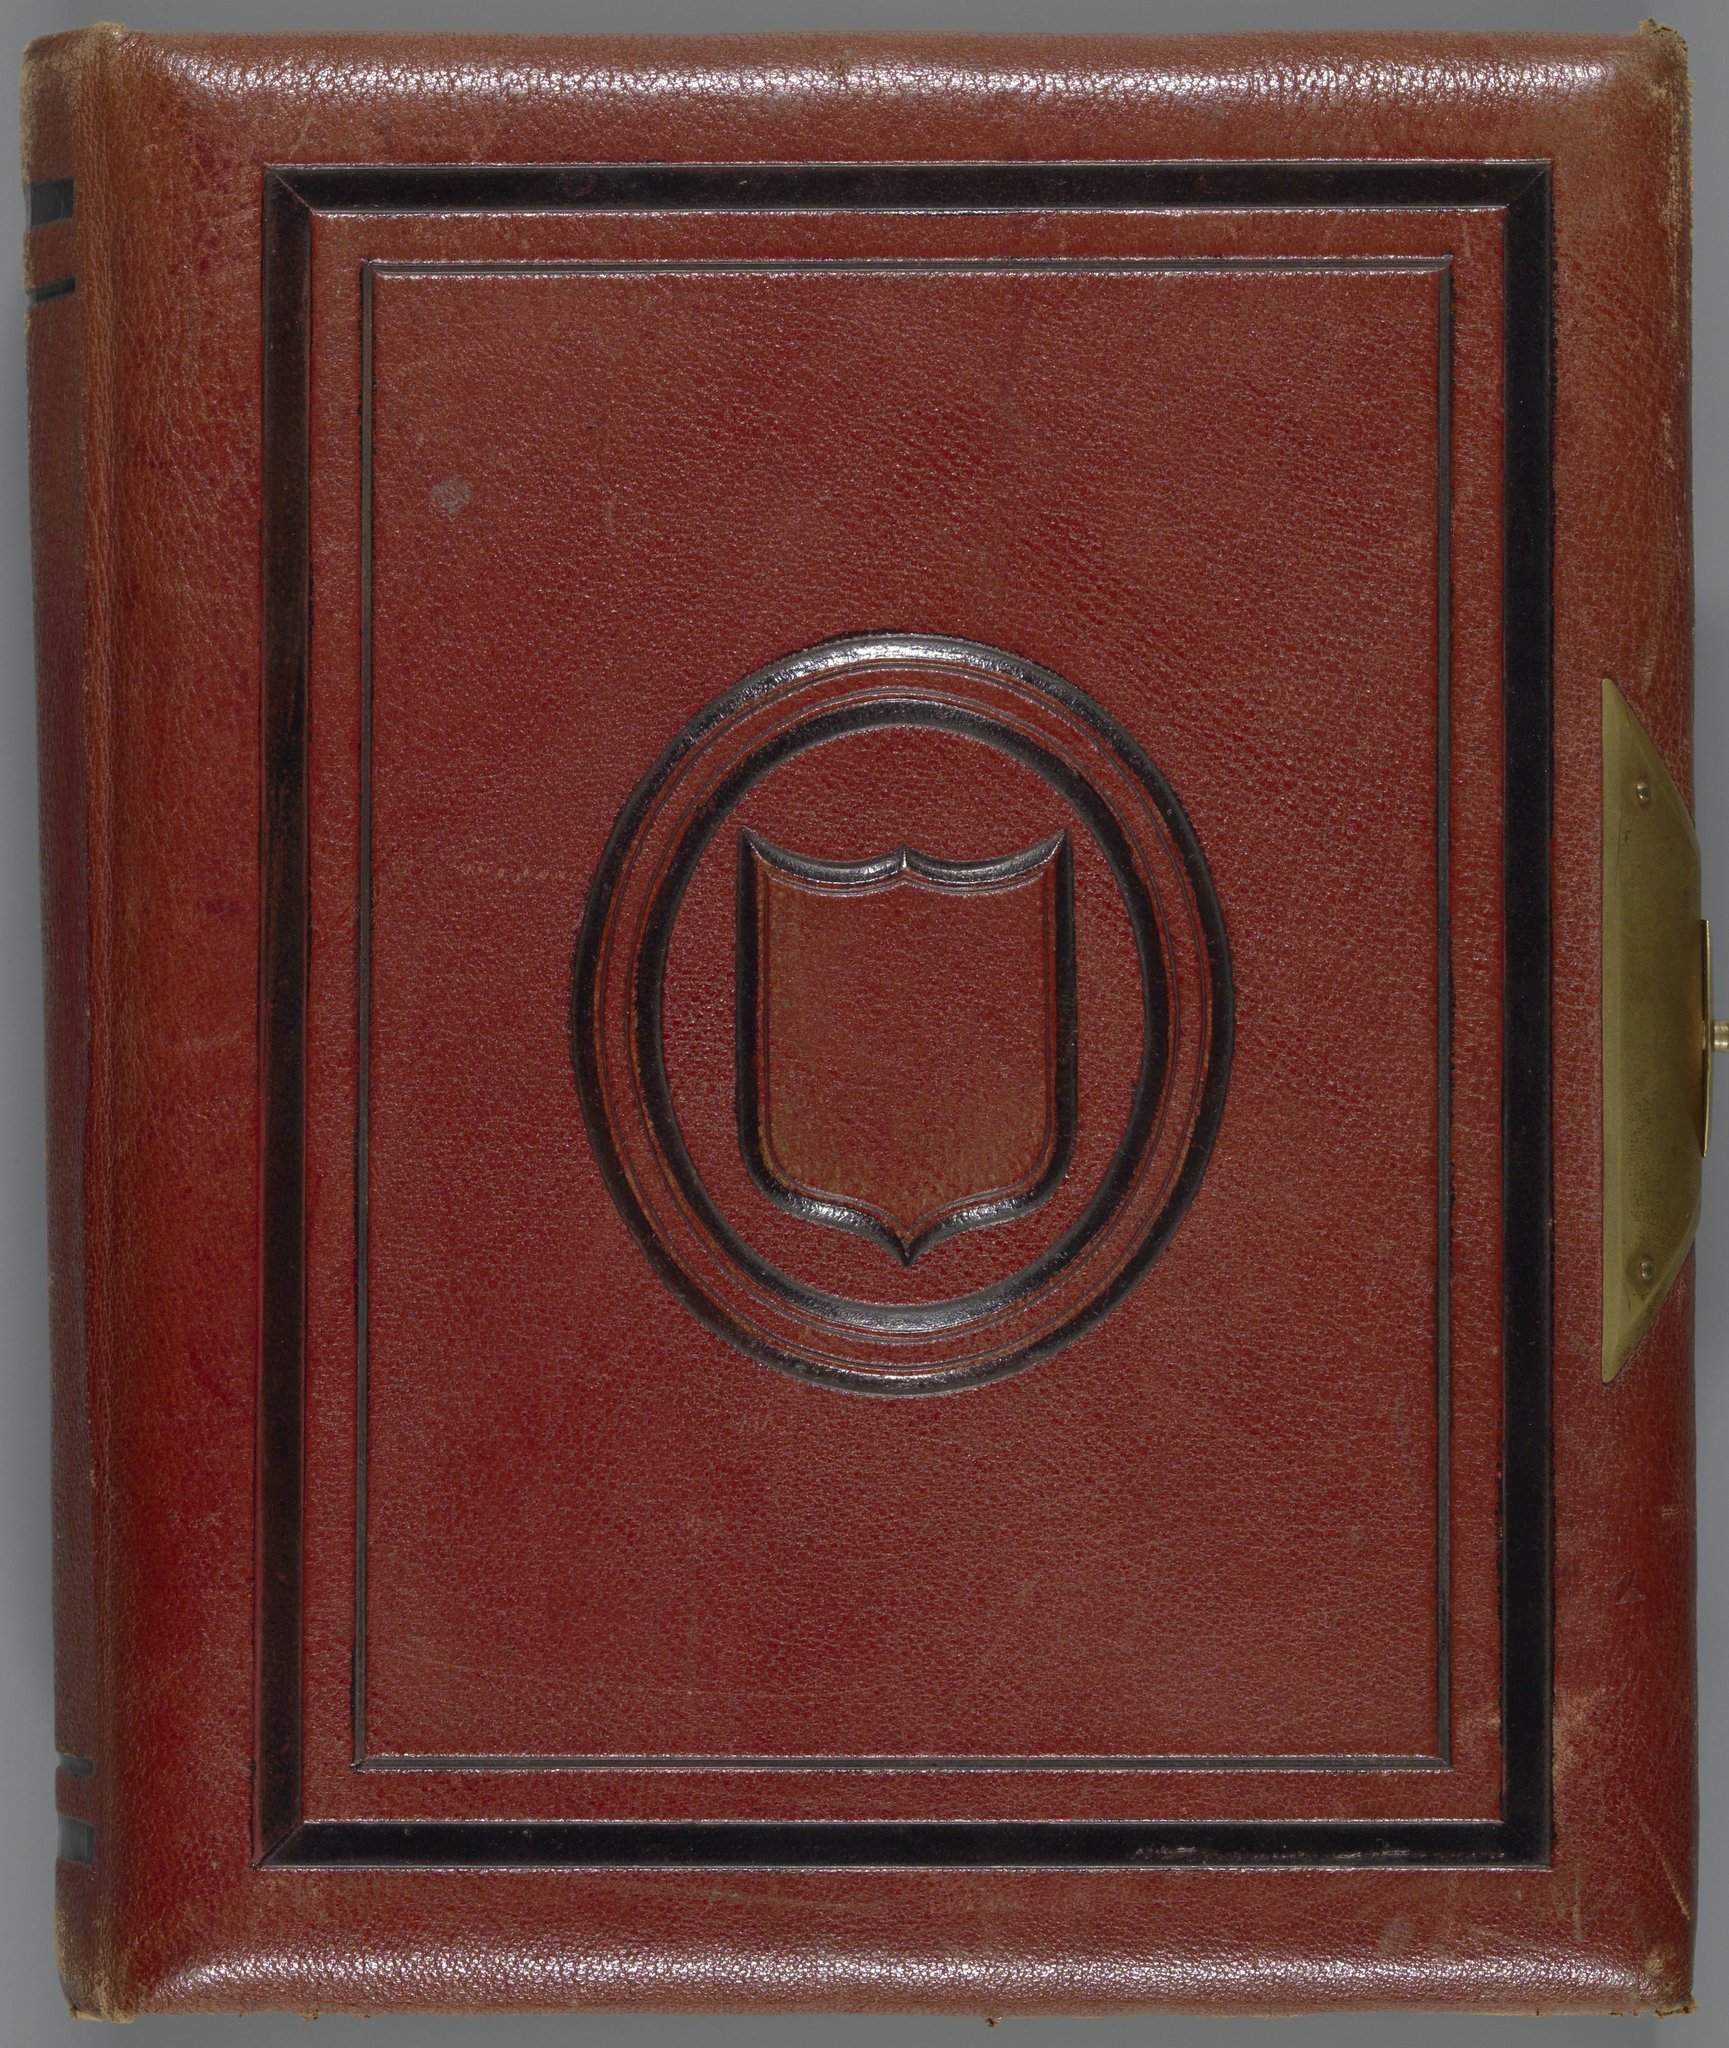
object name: slip in album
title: Fotoalbum met opnames van straten, pleinen en grachten in Amsterdam en van het 25-jarig regeringsjubileum van koning Willem III in 1874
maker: Anonymous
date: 1850-1875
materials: cardboard, copper, leather, paper, photographic support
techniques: albumen print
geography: amsterdam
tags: public festivities on the occasion of royal events, commemoration, jubilee (+ the public ~ festive activities), prospect of city, town panorama, silhouette of city, amsterdam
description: Fotoalbum in rode leren band met koperen slot. Het voor- en achterplat zijn versierd met een wapenschild en kaders in reliëf. De schutbladen zijn van changeant papier. Het album bevat 24 dikke kartonnen bladen goud op snee met in totaal 48 kabinetfoto's in passe-partouts. Daarvan hebben er 37 een bijschrift vermeld boven en/of onder het passe-partout. Ook heeft het merendeel van de kabinetfoto's op de rugzijde een opschrift (vaak in twee verschillende handschriften) dat inhoudelijk grotendeels overeenkomt met dat op het passe-partout. Het album geeft een beeld van Amsterdam in het derde kwart van de negentiende eeuw: straten, pleinen, grachten en gebouwen. Ook de versieringen en de poorten die in de hoofdstad opgericht werden ter gelegenheid van het 25-jarig regeringsjubileum van koning Willem III in 1874 komen aan bod.